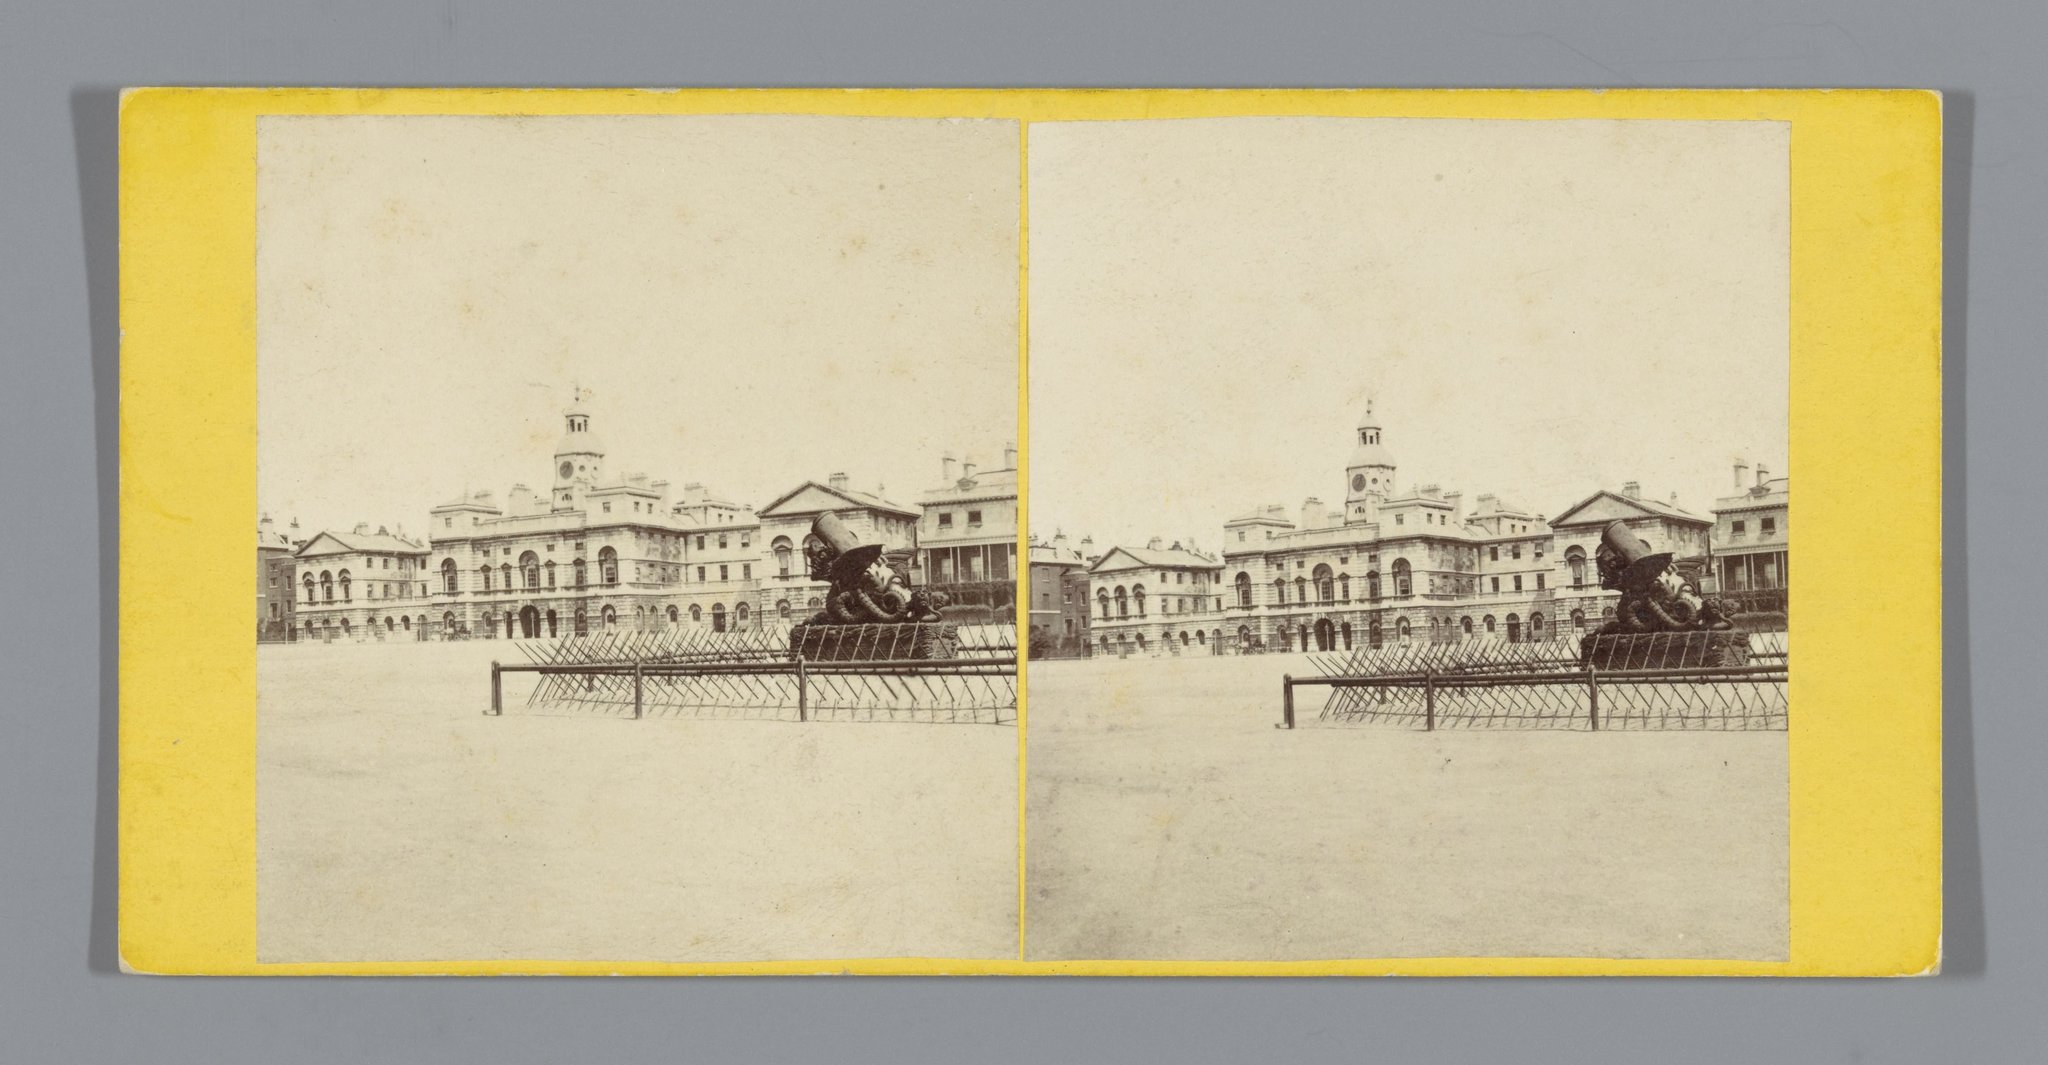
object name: stereograph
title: Gezicht op het Horse Guards Building in Londen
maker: Anonymous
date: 1850-1880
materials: cardboard, photographic support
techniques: albumen print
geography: london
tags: façade (of house or building)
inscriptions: number: ‘86’, inscription: ‘Horse Guards’